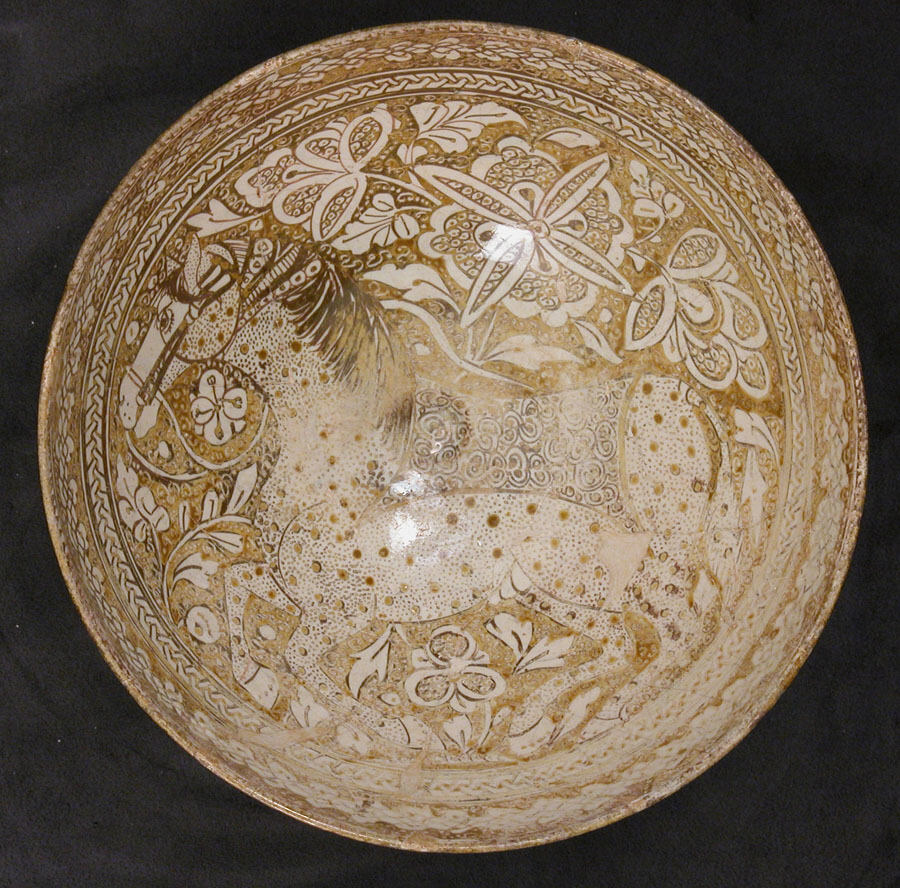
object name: bowl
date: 1300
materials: glaze, stonepaste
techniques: luster painting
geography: iran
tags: horses